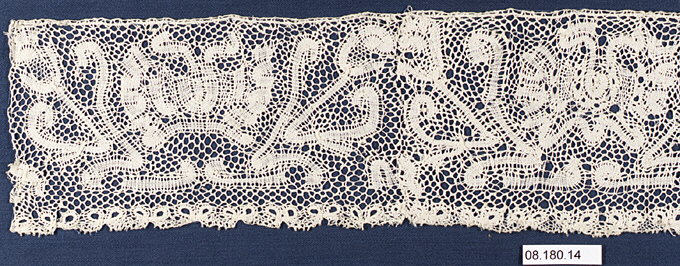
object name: fragment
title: Fragment of lace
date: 1801-1900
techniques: lace